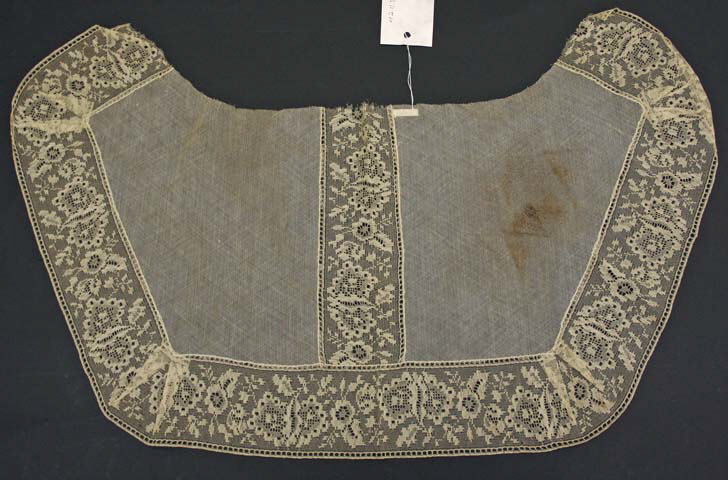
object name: collar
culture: american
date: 1700-1942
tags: flowers